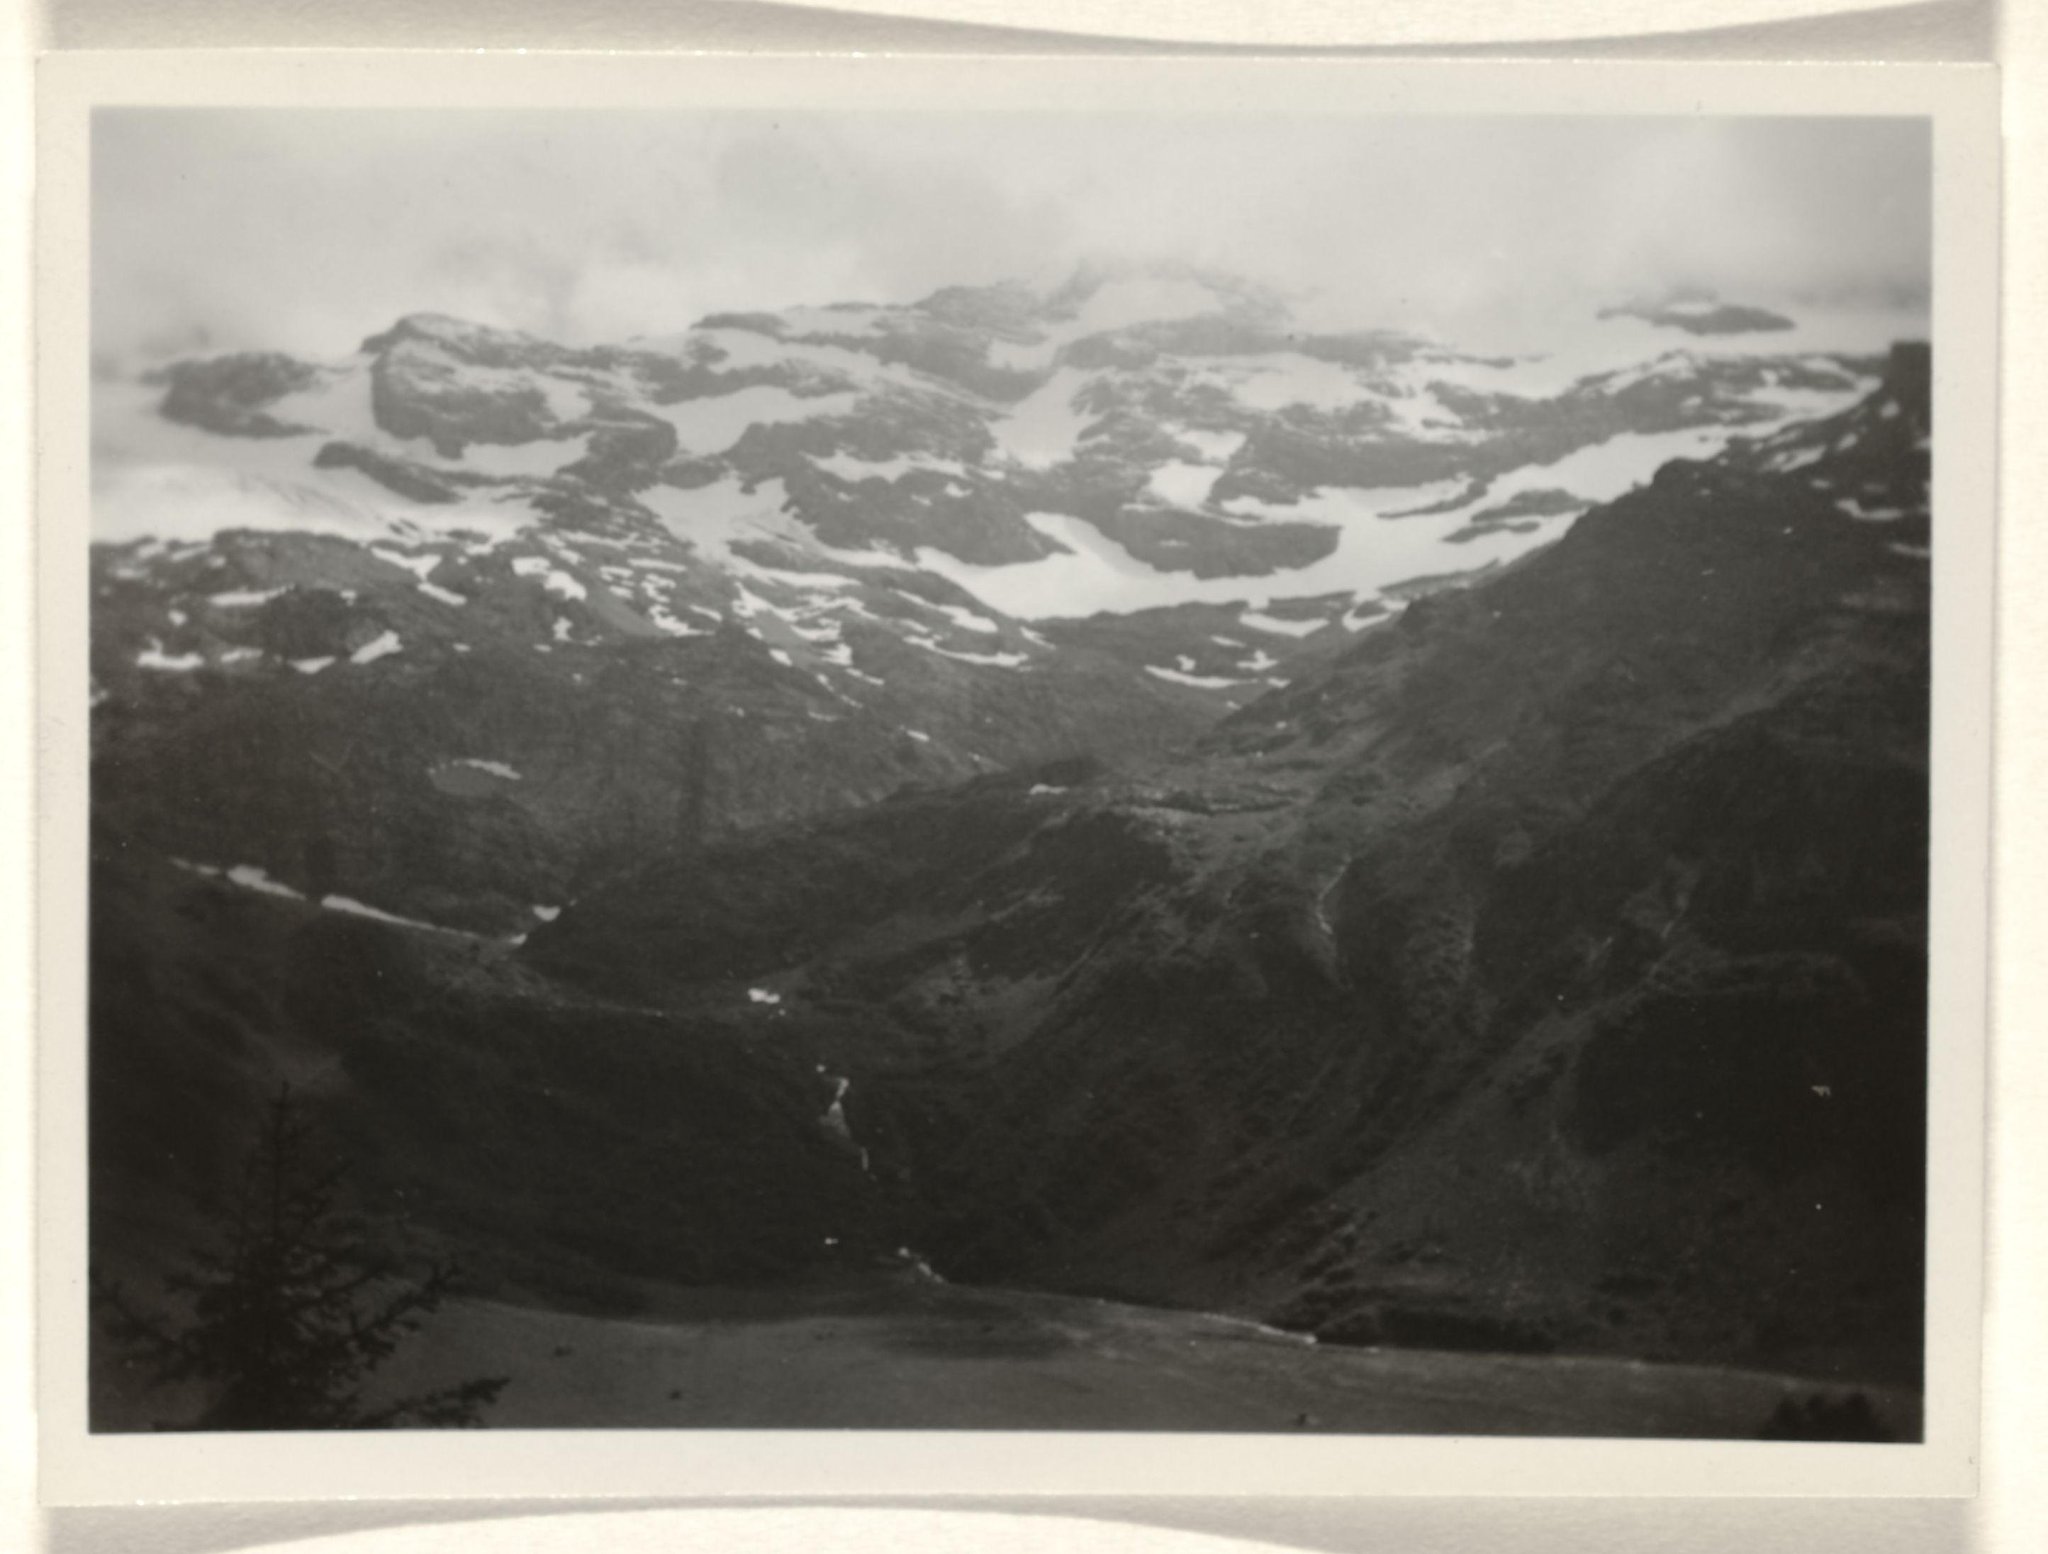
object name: photograph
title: Besneeuwd berglandschap met graslandschap op de voorgrond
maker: Anonymous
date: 1908-1935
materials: photographic support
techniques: gelatin silver print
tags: trübsee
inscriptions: date: ‘Aug. 1935 28’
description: Besneeuwd berglandschap met graslandschap op de voorgrond.